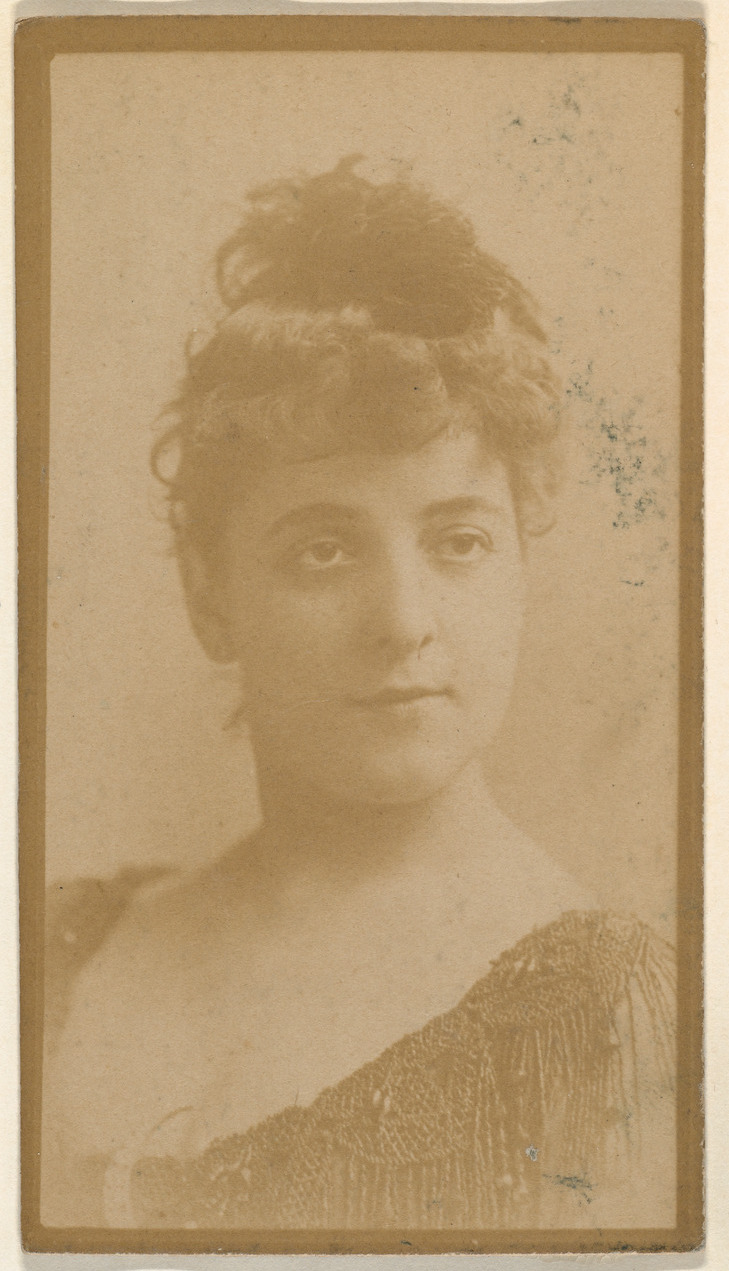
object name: photograph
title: Portrait of actress, from the Actresses series (N668)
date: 1888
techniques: albumen silver print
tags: portraits,women,actresses